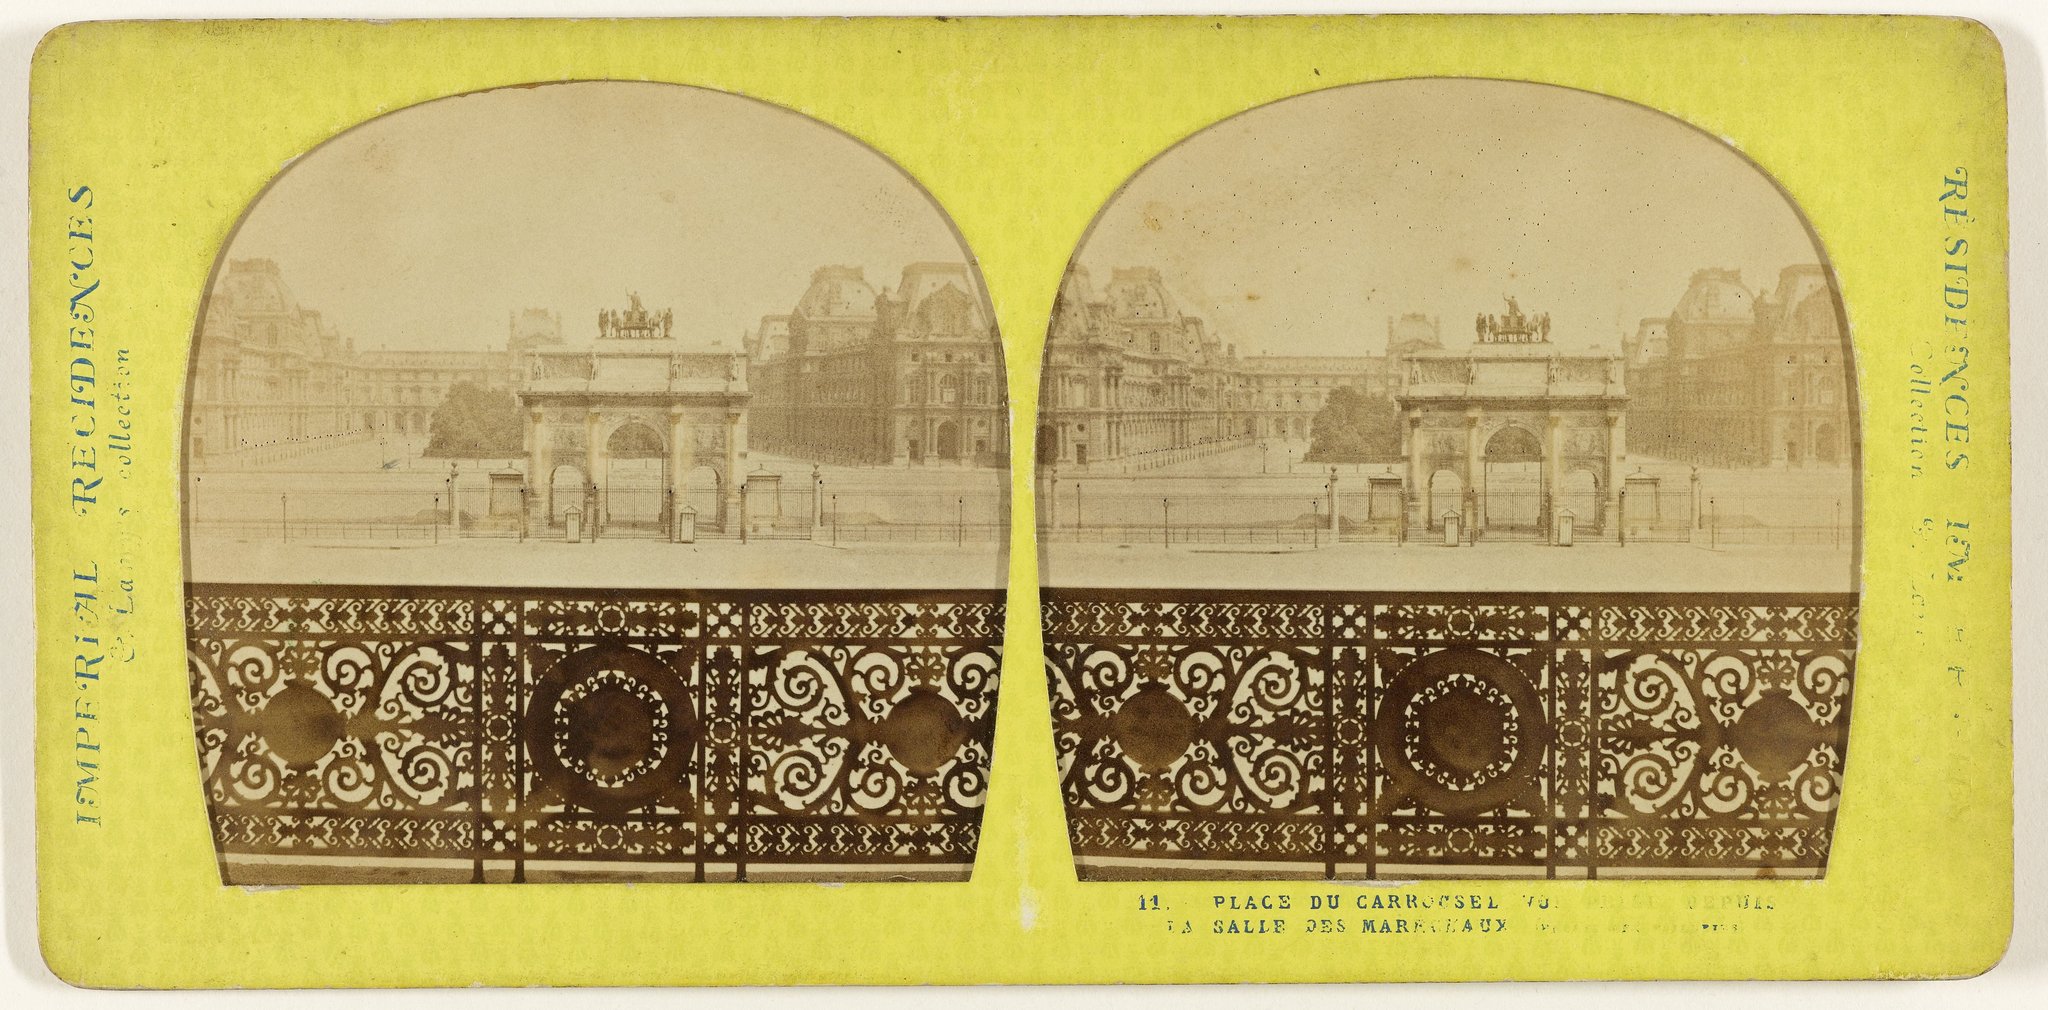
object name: tissue stereograph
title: Résidences Impériales Collection E. Lamy, Imperial Recidences E. Lamy collection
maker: ernest eléonor pierre lamy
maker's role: publisher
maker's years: 1828-1900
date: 1860-1870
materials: paper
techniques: albumen print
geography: paris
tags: monumental adornments (in city), paris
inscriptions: annotation: ‘IMPERIAL RECIDENCES / E. Lamy collection // RÉSIDENCES IMPÉRIALES / Collection E. Lamy // 11. PLACE DU CARROUSEL , VUE PRISE DEPUIS / LA SALLE DES MARÉCHAUX, (PALAIS DES RUILERIES)’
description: Gezicht op Place du Carroussel en Arc du Carrousel, Parijs, gezien vanuit de Salle des Maréchaux van het Palais des Tuileries, met een balkonhek op de voorgrond als repoussoir.